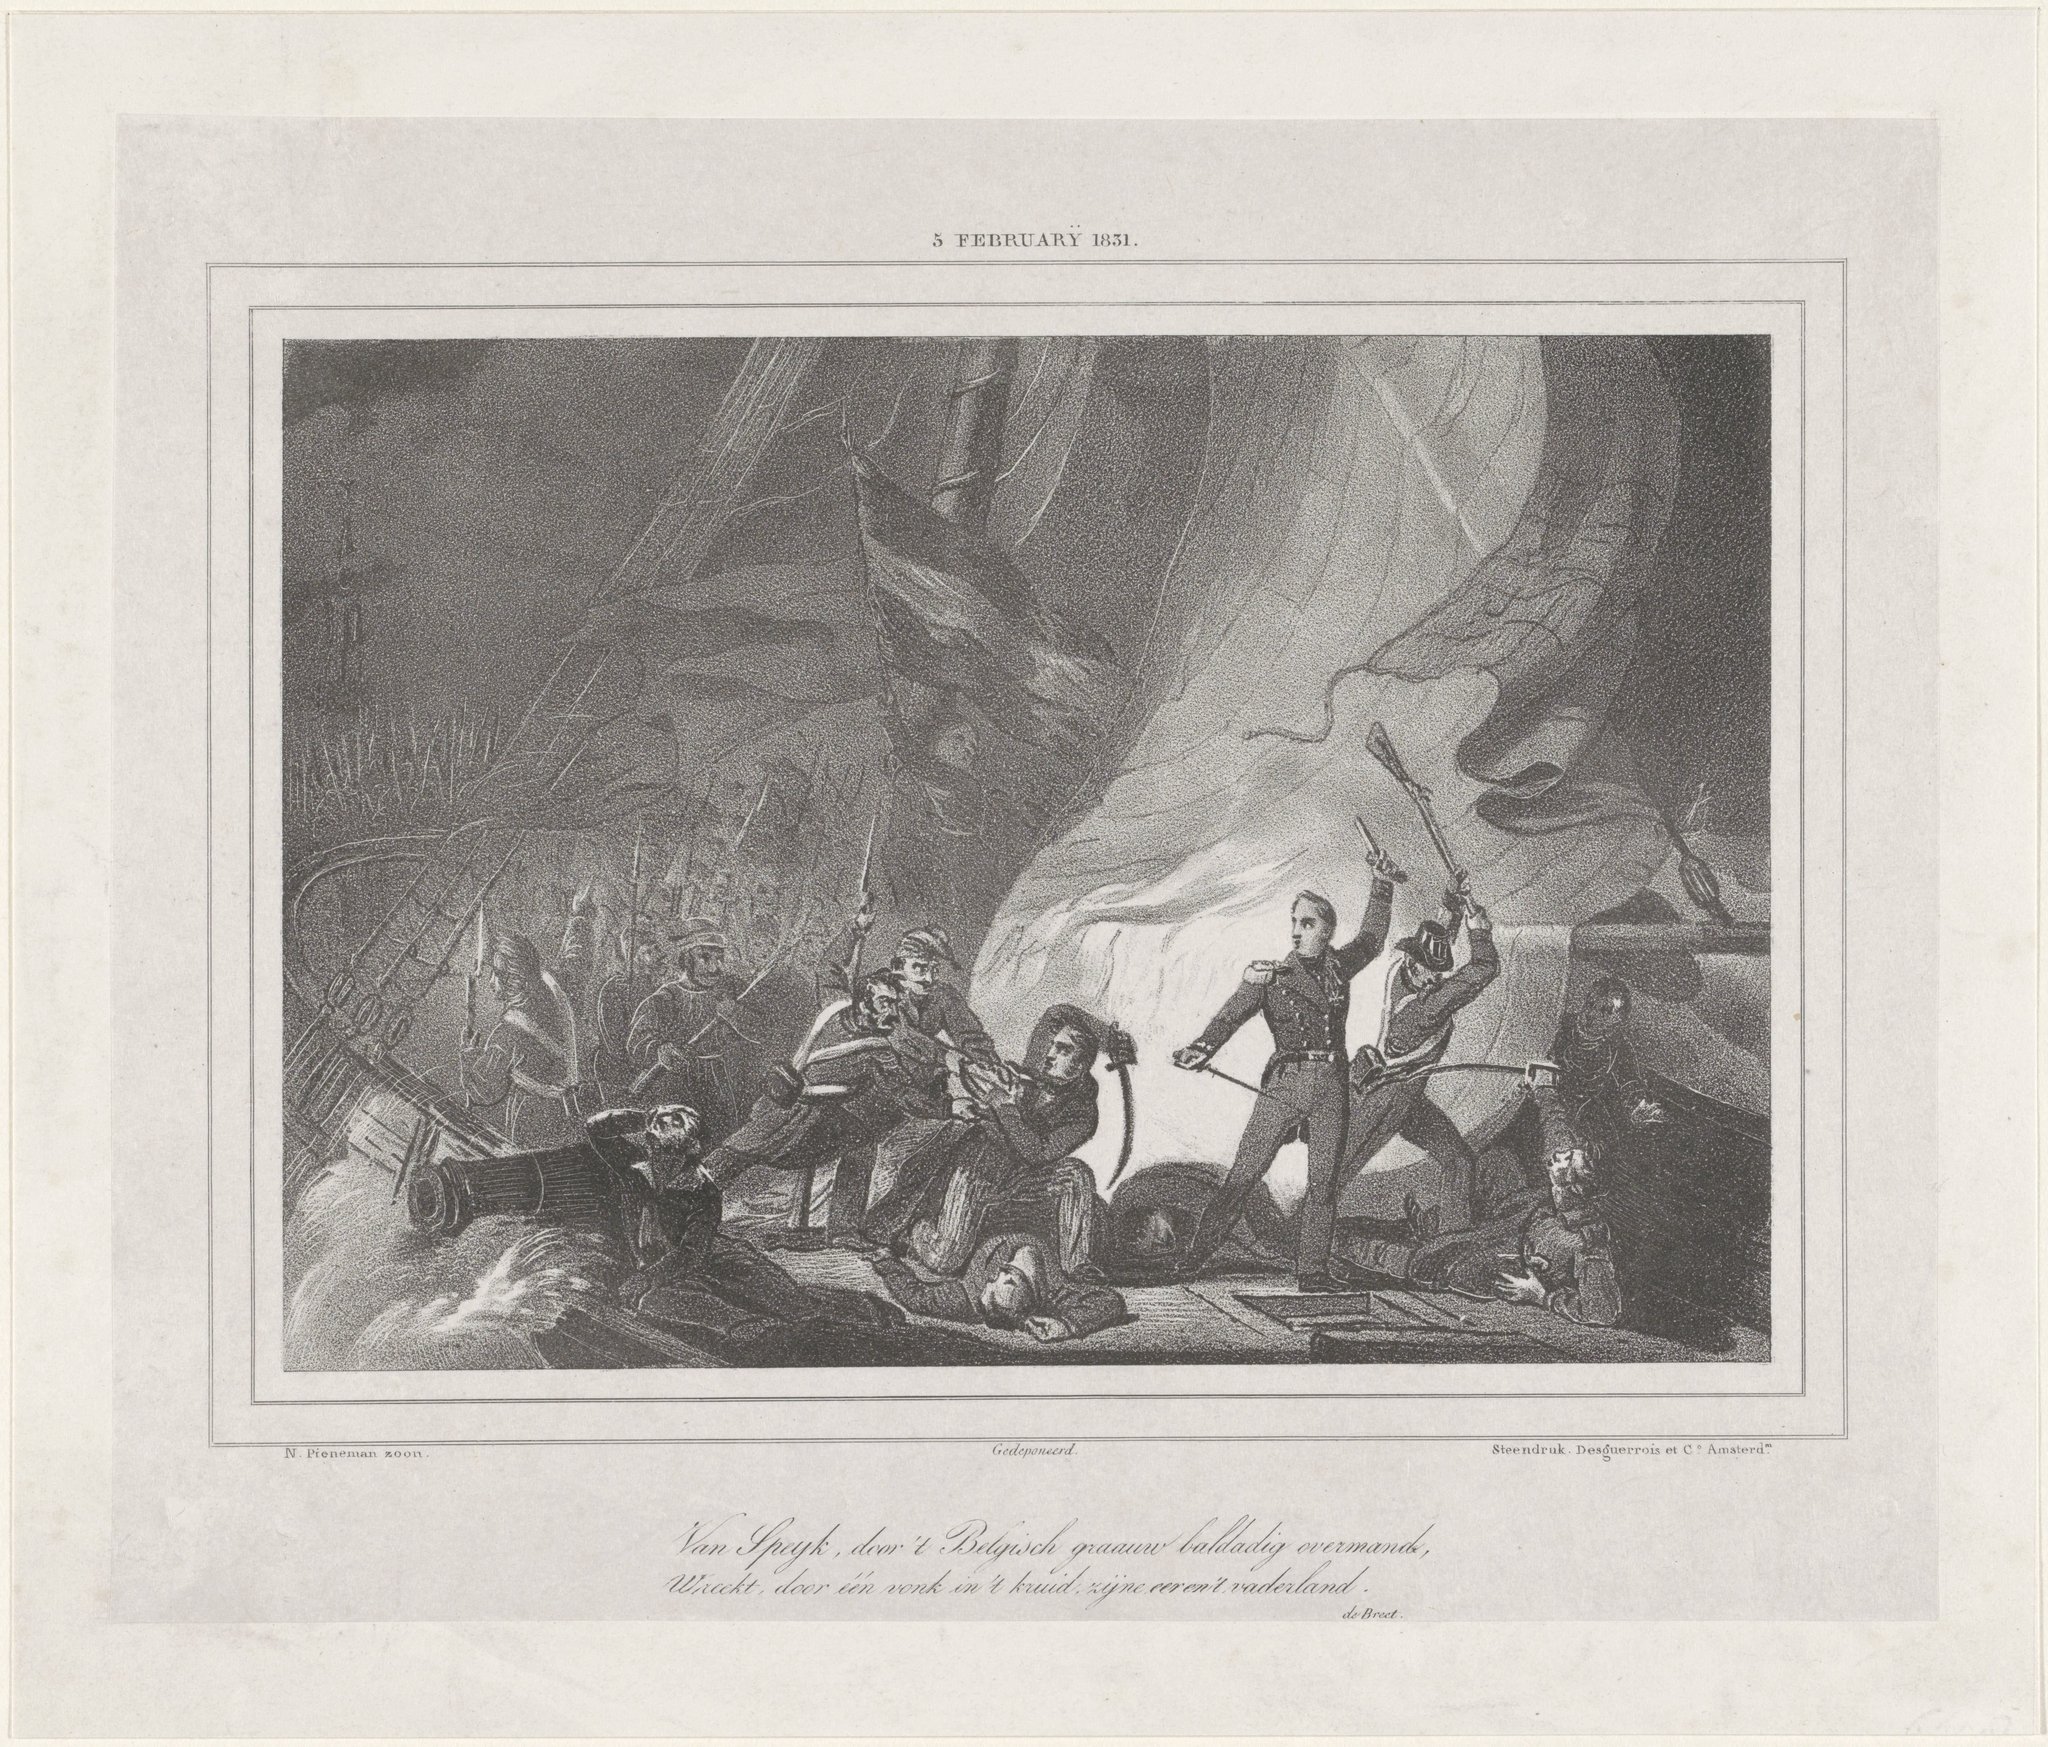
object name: print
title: 5 Februarij 1831. Van Speijk, door 't Belgisch graauw baldadig overmand, Wreekt, dor één vonk in 't kruid, zijne eer en 't vaderland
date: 1831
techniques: printmaking, lithograph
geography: netherlands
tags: amsterdam, antwerp, jan van speyk, navy (+ sailing-ships)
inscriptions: collector's mark: Lugt 2228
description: De kanonneerboot van Jan van Speyk overrompeld door Belgische opstandelingen. Jan van Speyk staat met pistool in opgeheven hand bij de kajuitstrap, 5 februari 1831.